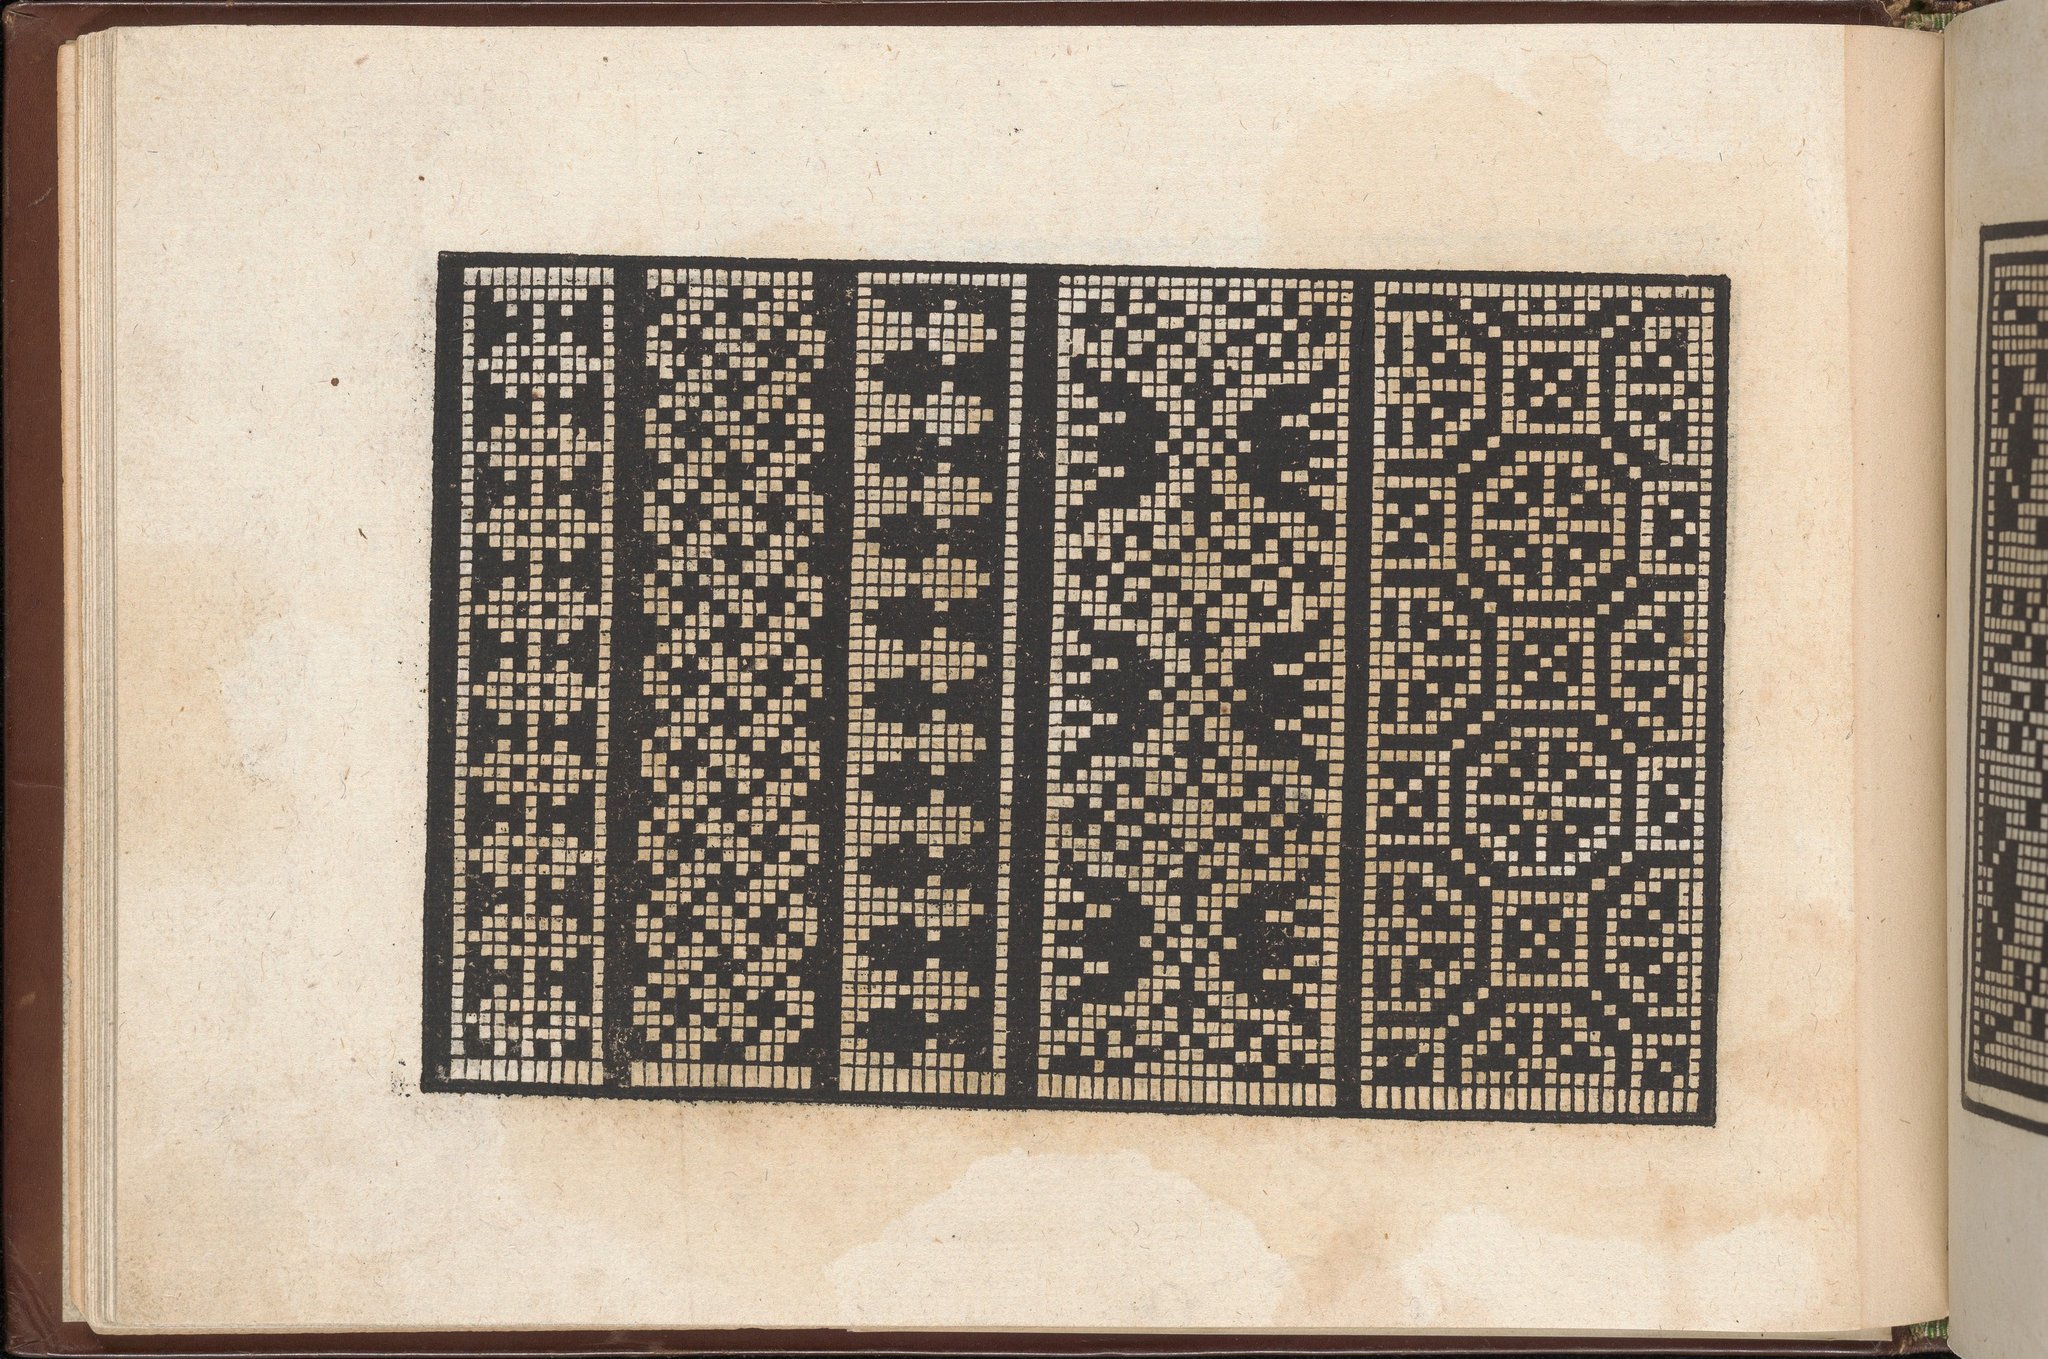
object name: book print ornament architecture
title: Page from Eyn Newe kunstlich moetdelboech alle kunst (Page 15v)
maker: peter quentel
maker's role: publisher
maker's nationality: german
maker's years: 1500-1550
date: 1532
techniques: woodcut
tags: ornament